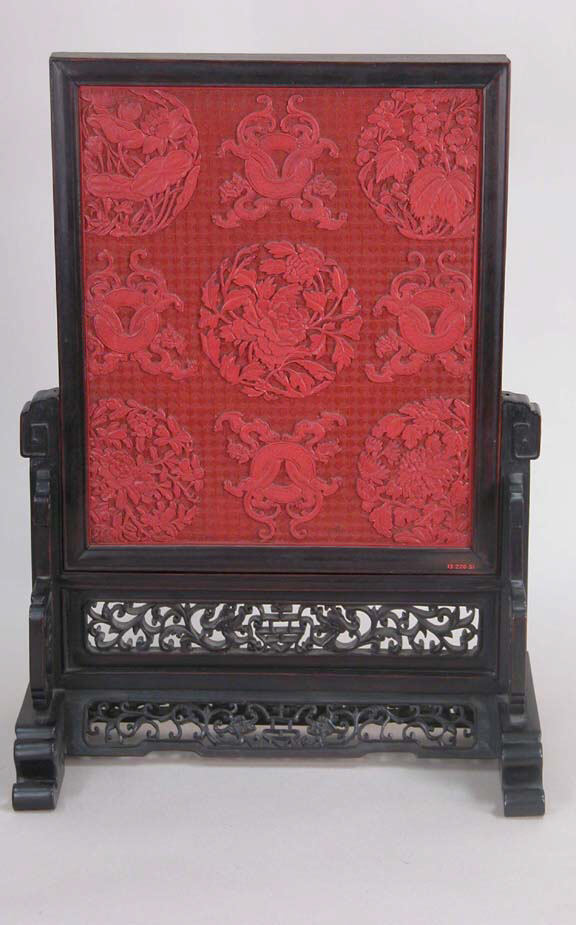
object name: table screen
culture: chinese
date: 1736-1795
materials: lacquer